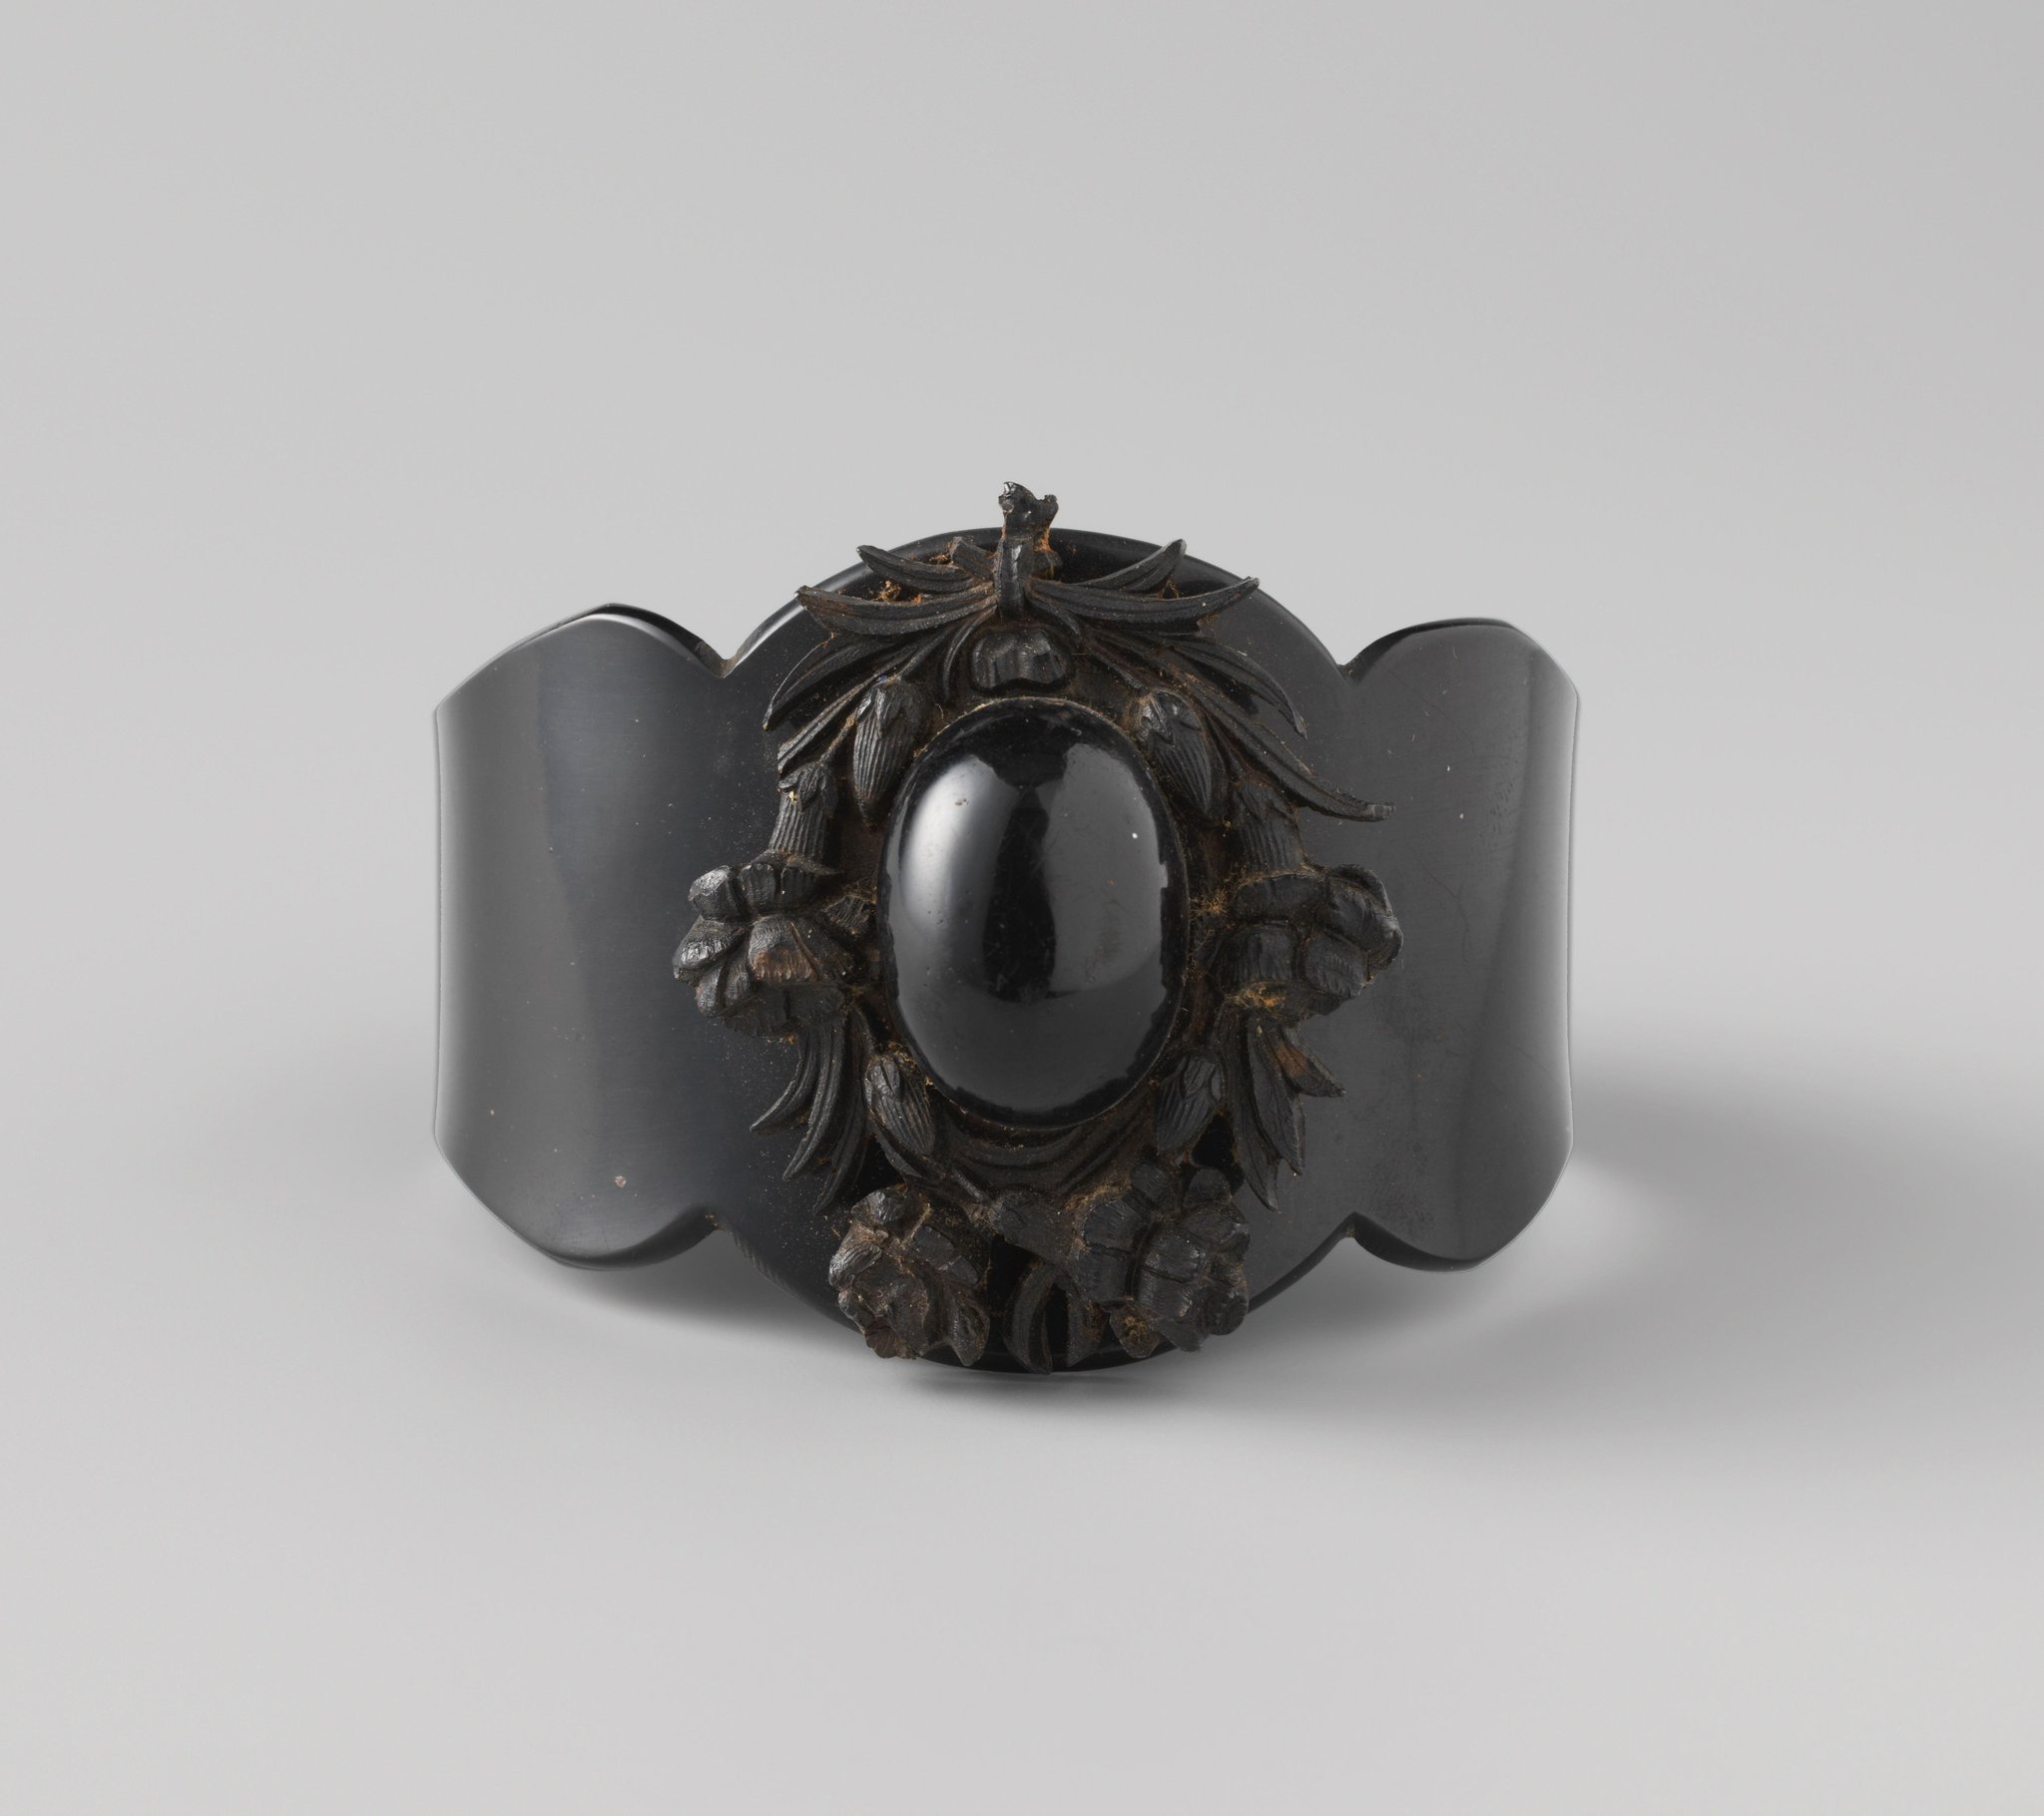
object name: bracelet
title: Armband van balein, breed van voren en enigszins gegolfd. Op bovenkant een krans van bloemen en bladeren met in het midden een ovaal.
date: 1865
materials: baleen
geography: great britain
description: Armband van balein, breed van voren en enigszins gegolfd.Op de bovenkant is een krans van bloemen en dunne blaadjes aangebracht met in het midden een ovaal.